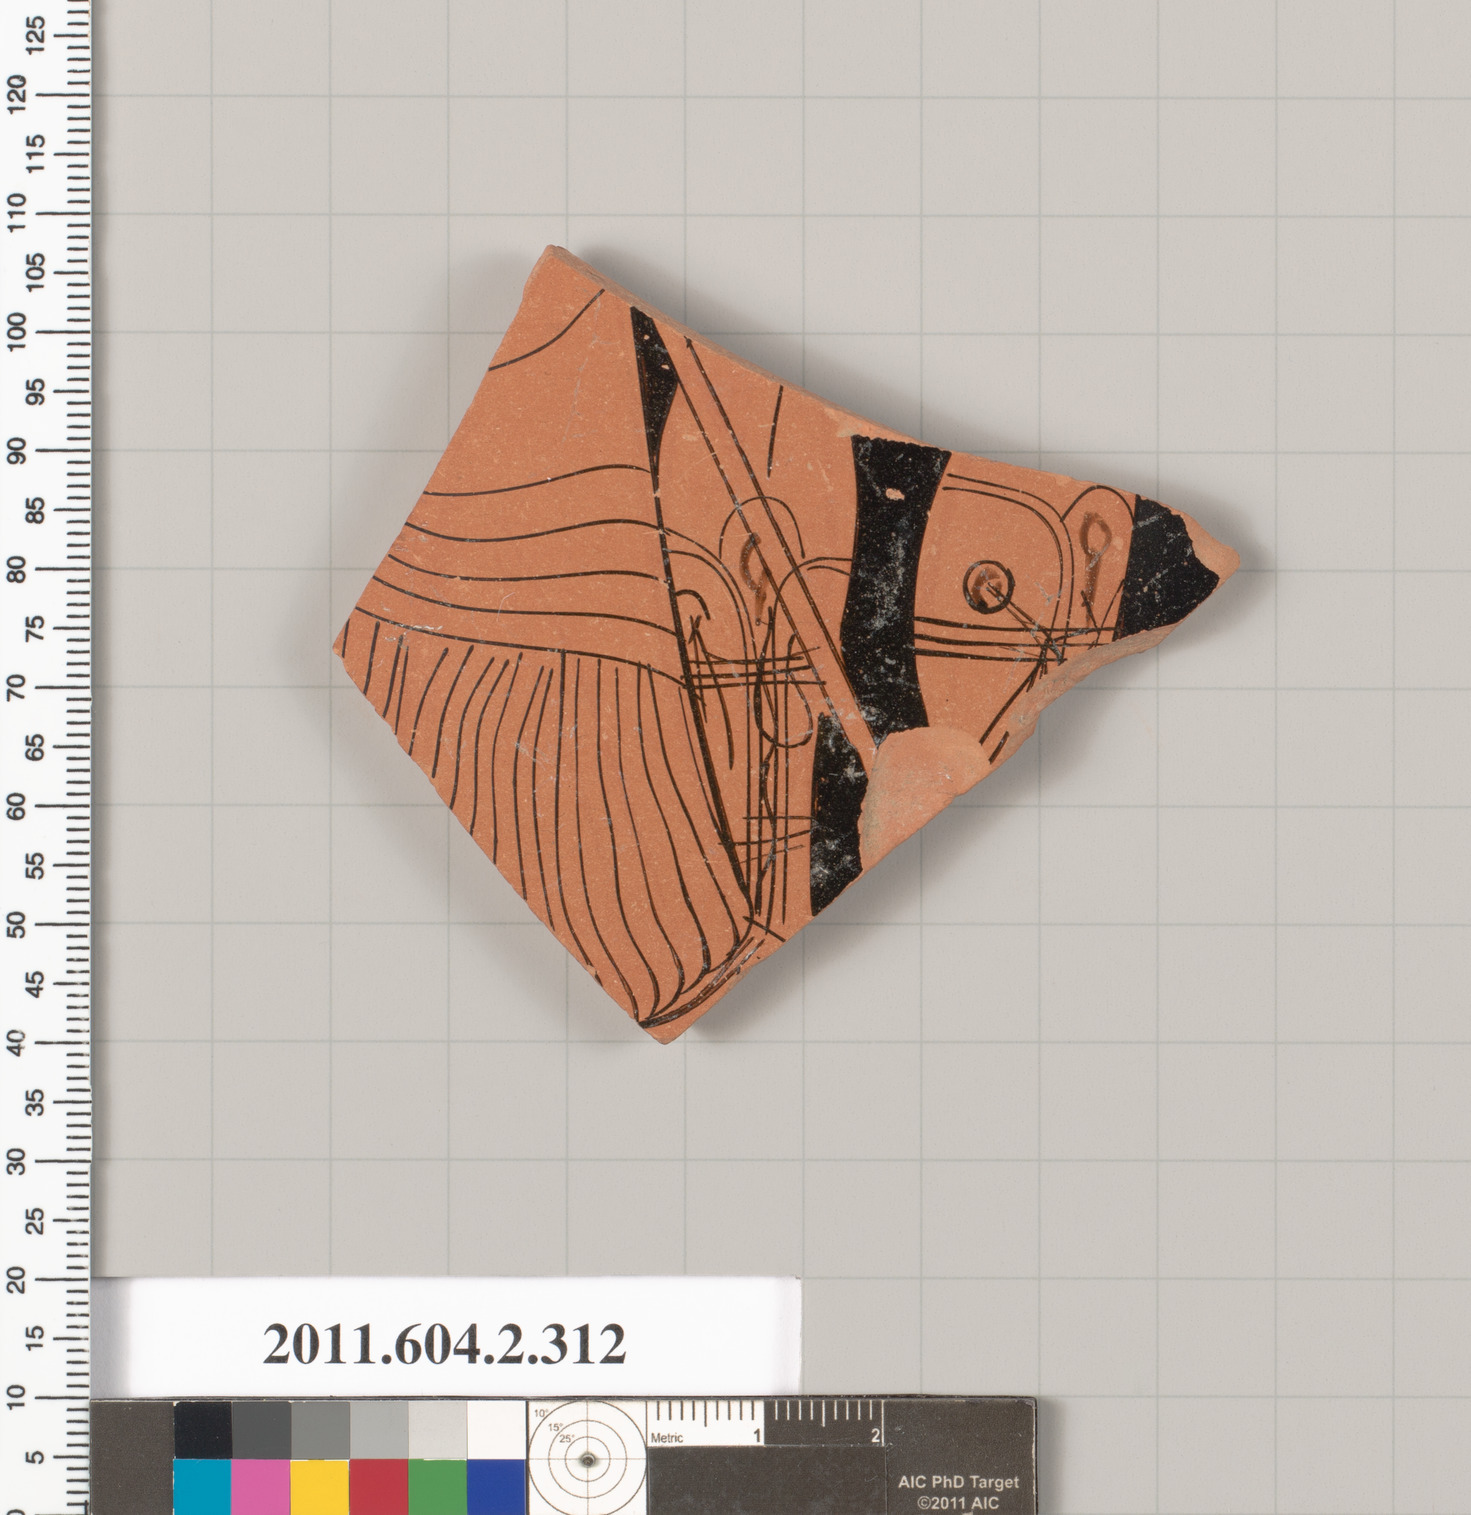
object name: column krater fragment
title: Terracotta fragment of a column-krater (bowl for mixing wine and water)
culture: greek, attic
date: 460-440 BCE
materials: terracotta